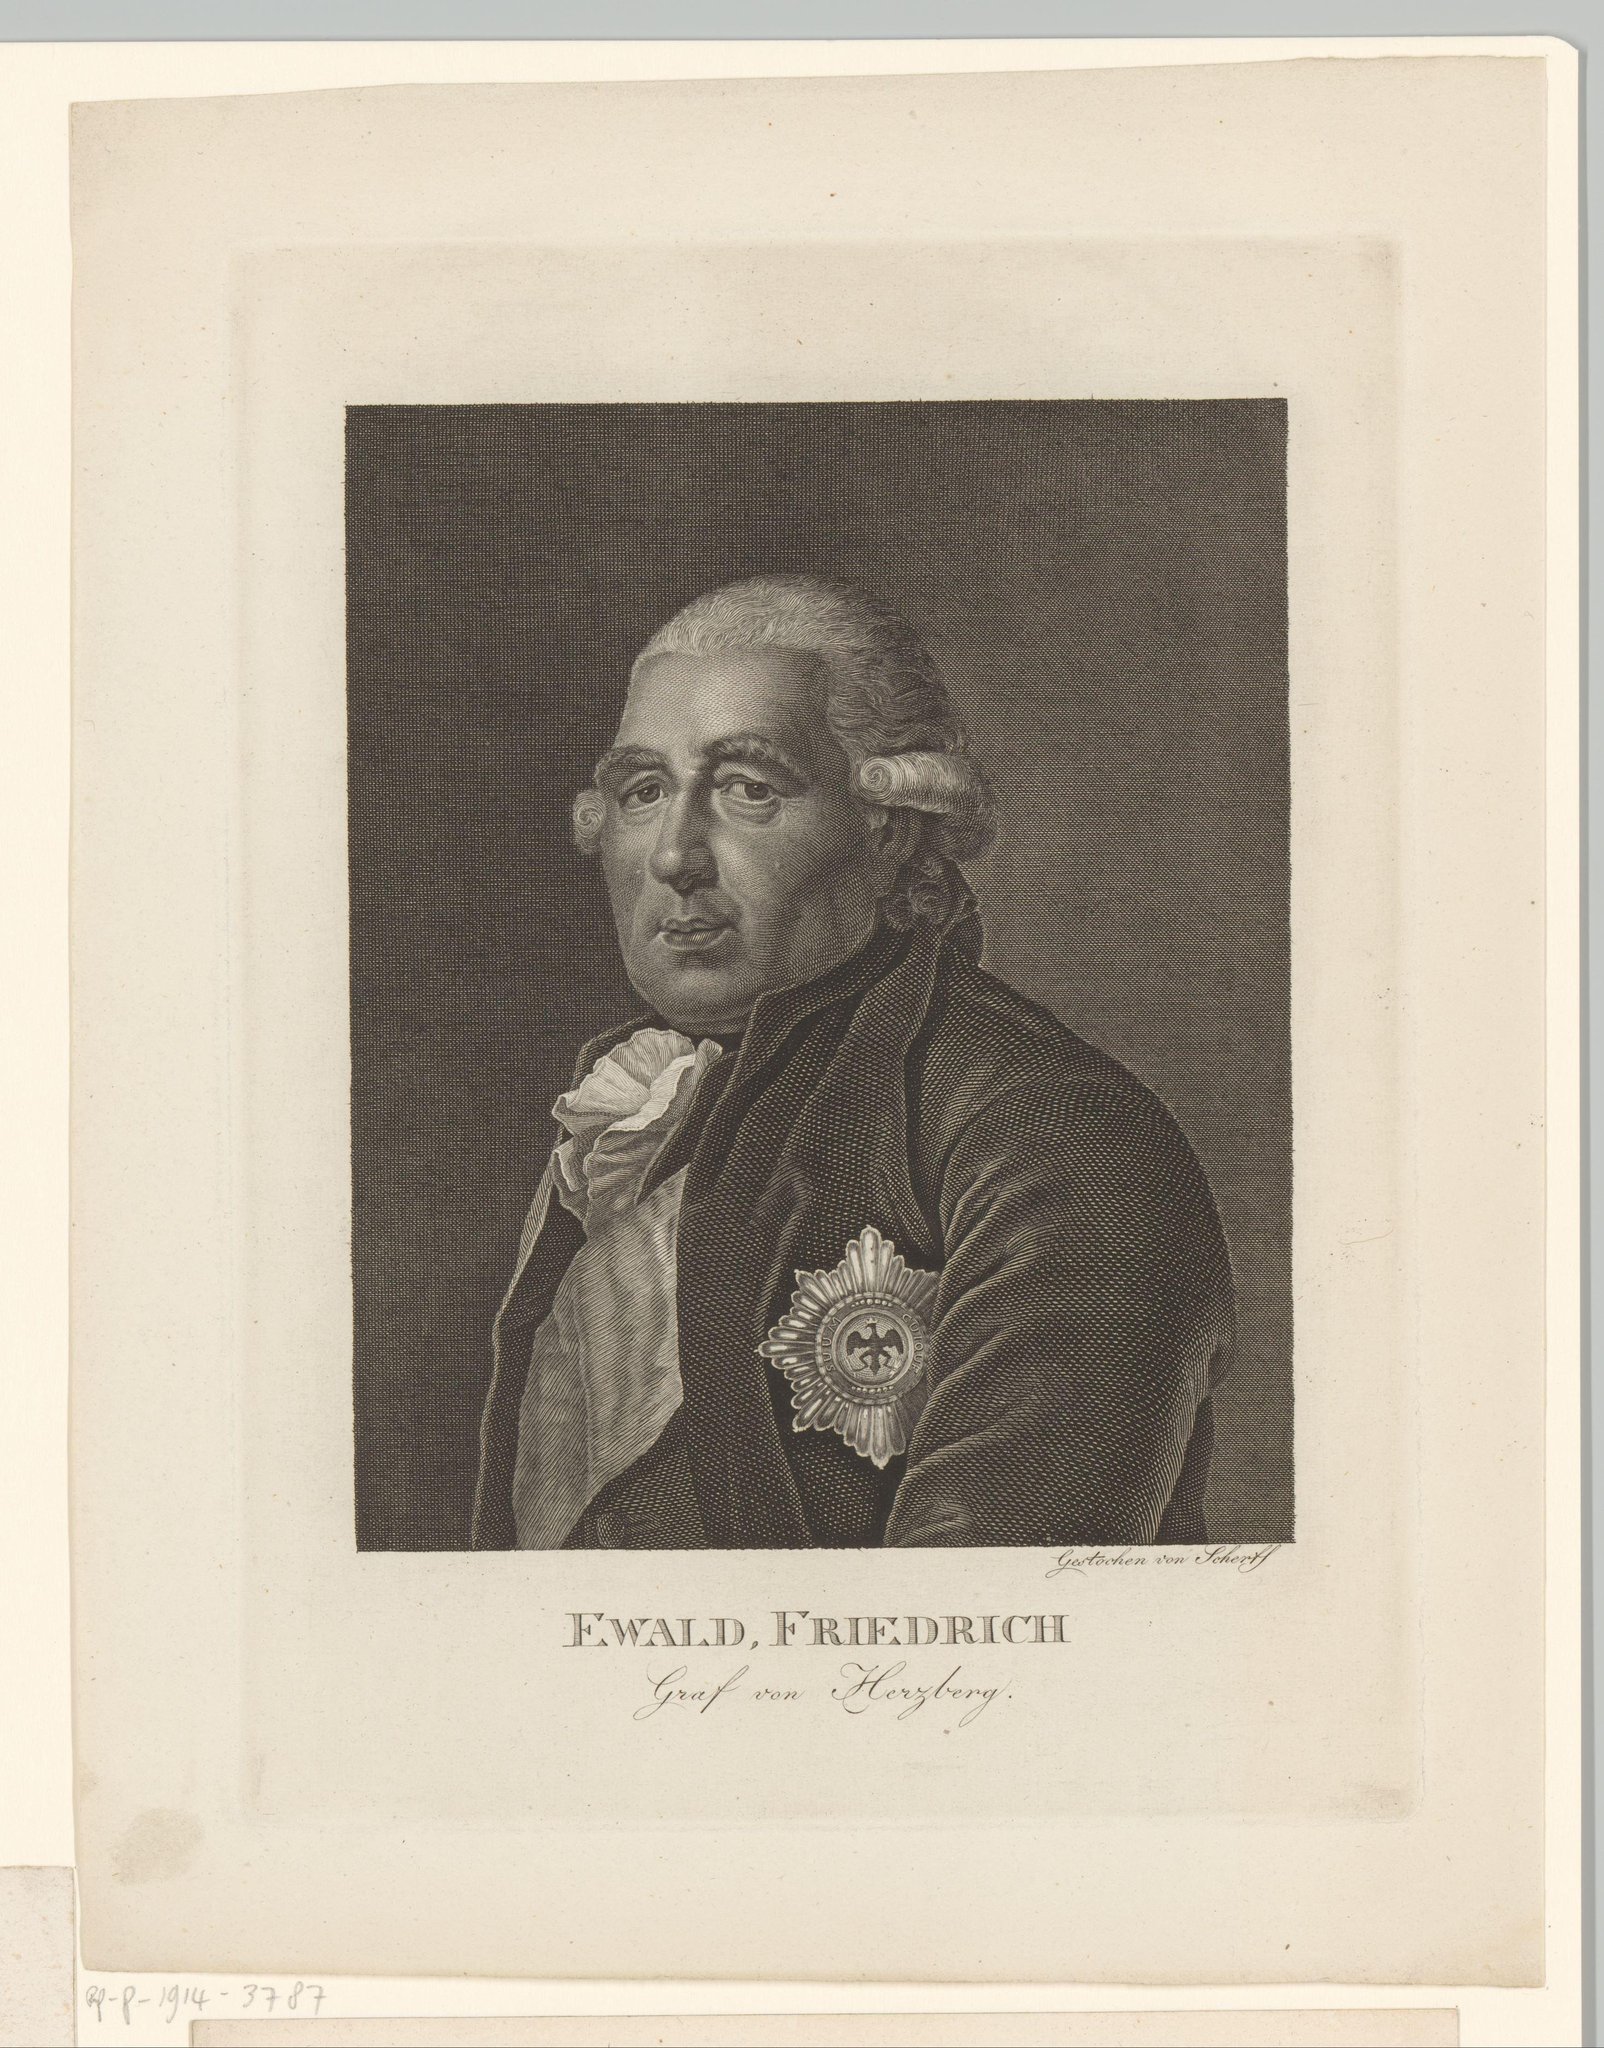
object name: print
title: Portret van Ewald Friedrich von Hertzberg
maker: christian gottlob scherf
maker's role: print maker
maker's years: 1793-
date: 1803-1849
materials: paper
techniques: engraving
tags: poland, berlin, ewald friedrich von hertzberg (graaf), knighthood order (red eagle order), historical persons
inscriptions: collector's mark: Lugt 2228